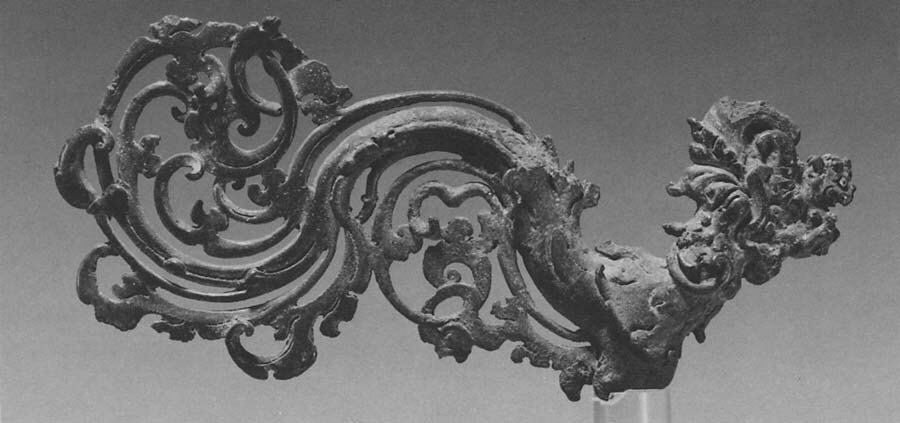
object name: finial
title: Finial with a Makara Disgorging a Lion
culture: indonesian, javanese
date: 901-925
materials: bronze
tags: mythical creatures